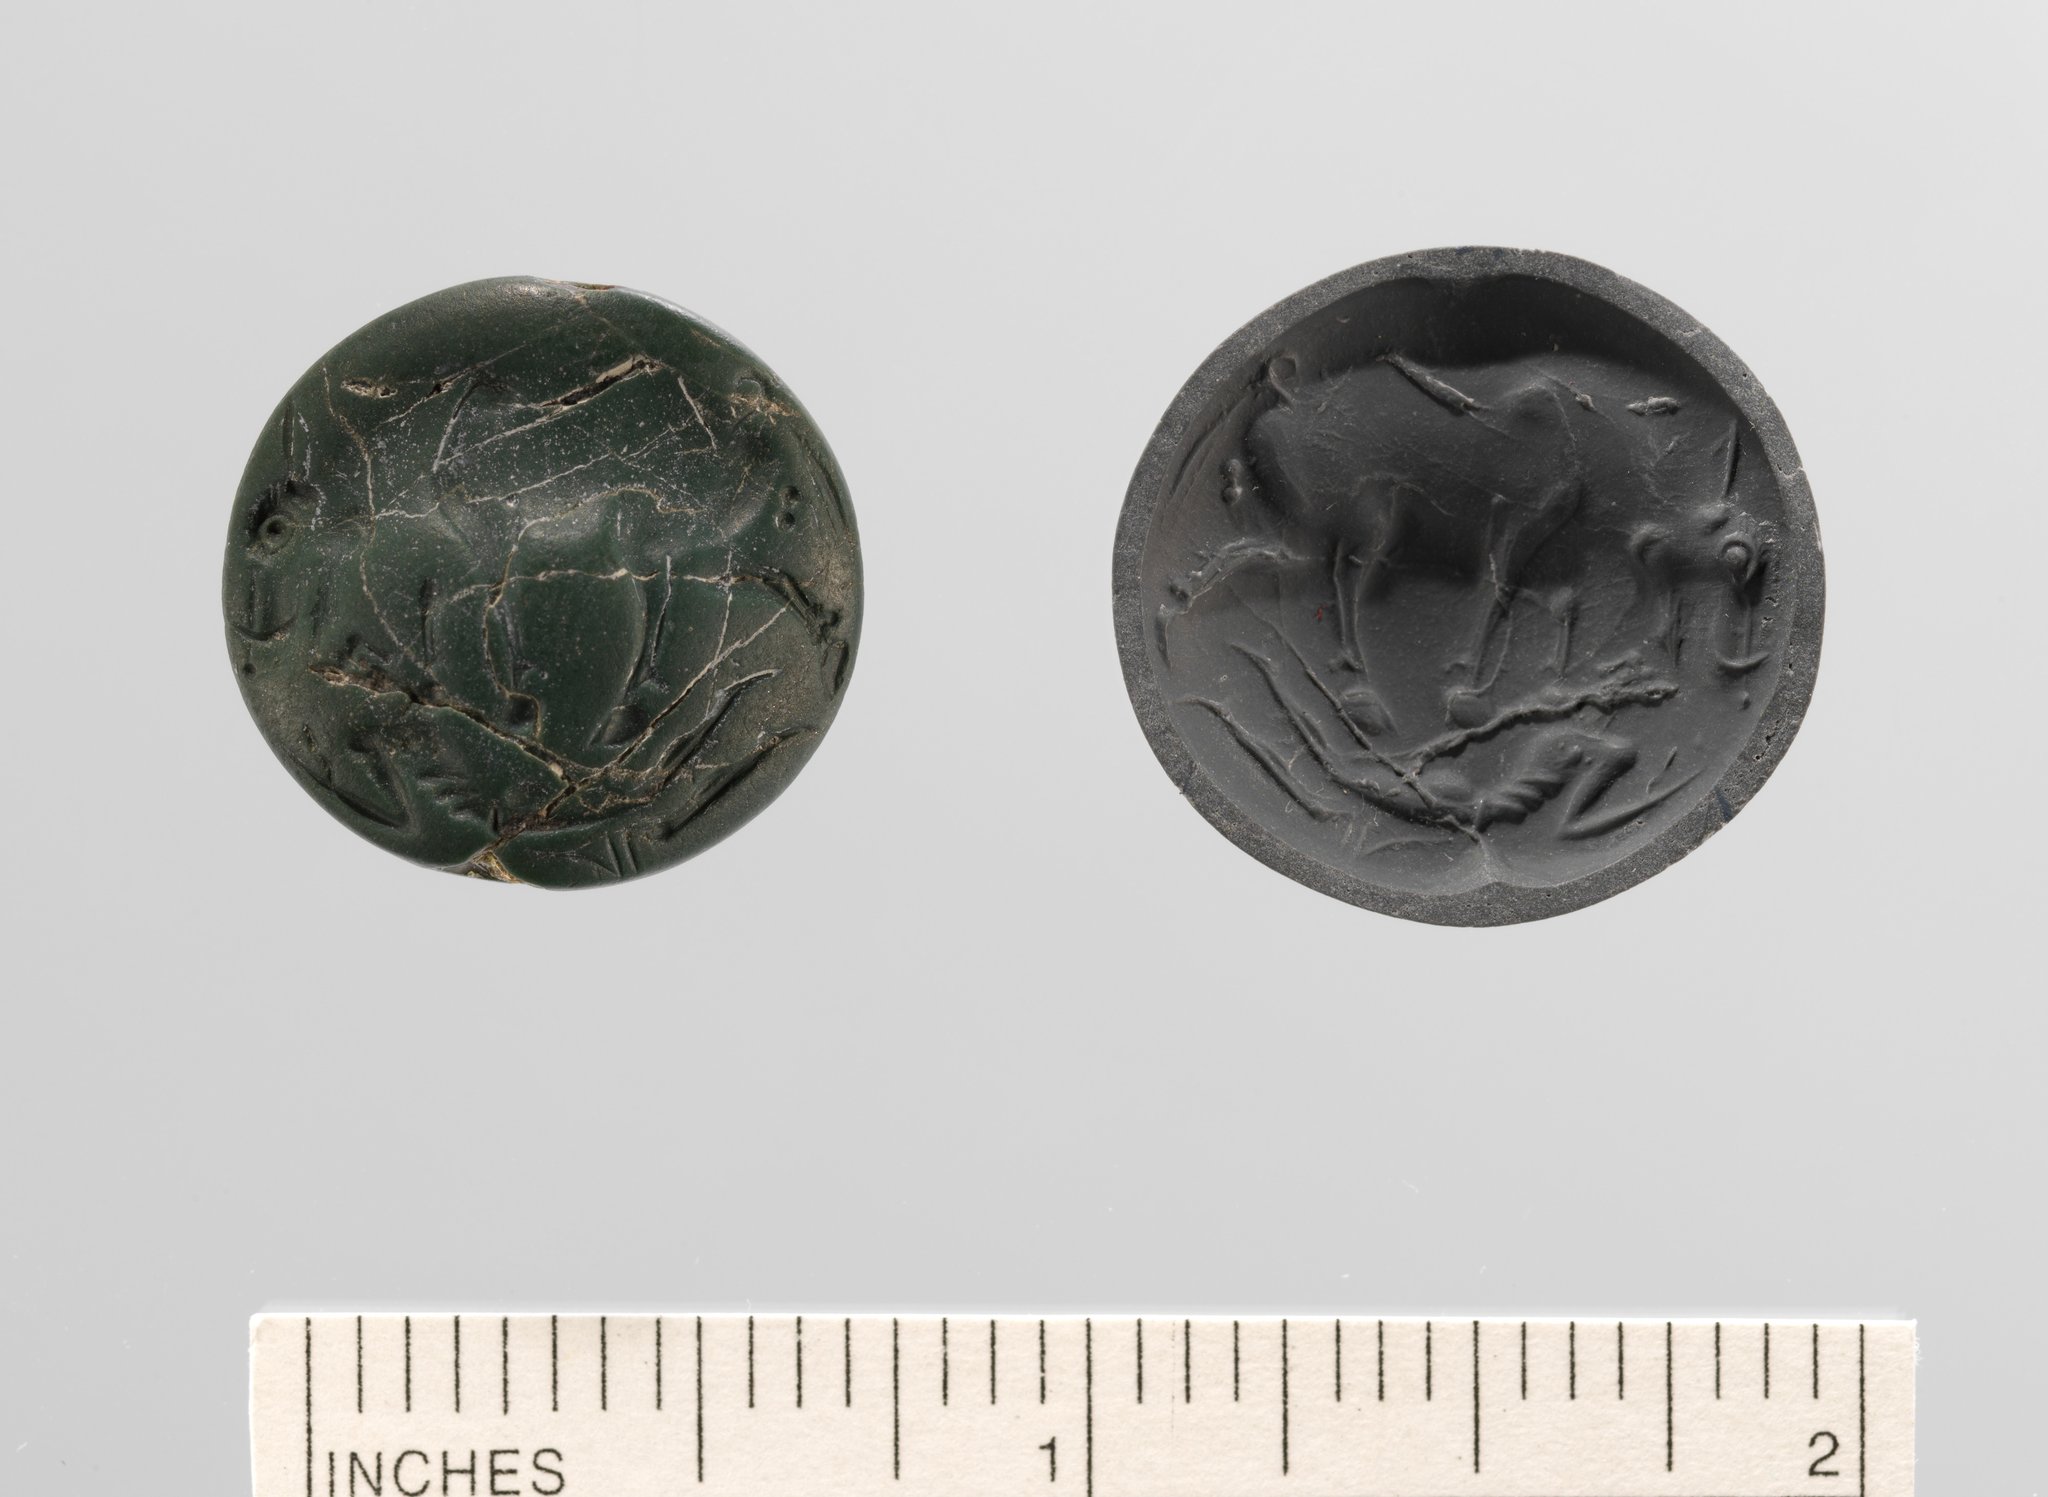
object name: seal, lentoid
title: Jasper Lentoid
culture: minoan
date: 1500-1450 BCE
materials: jasper